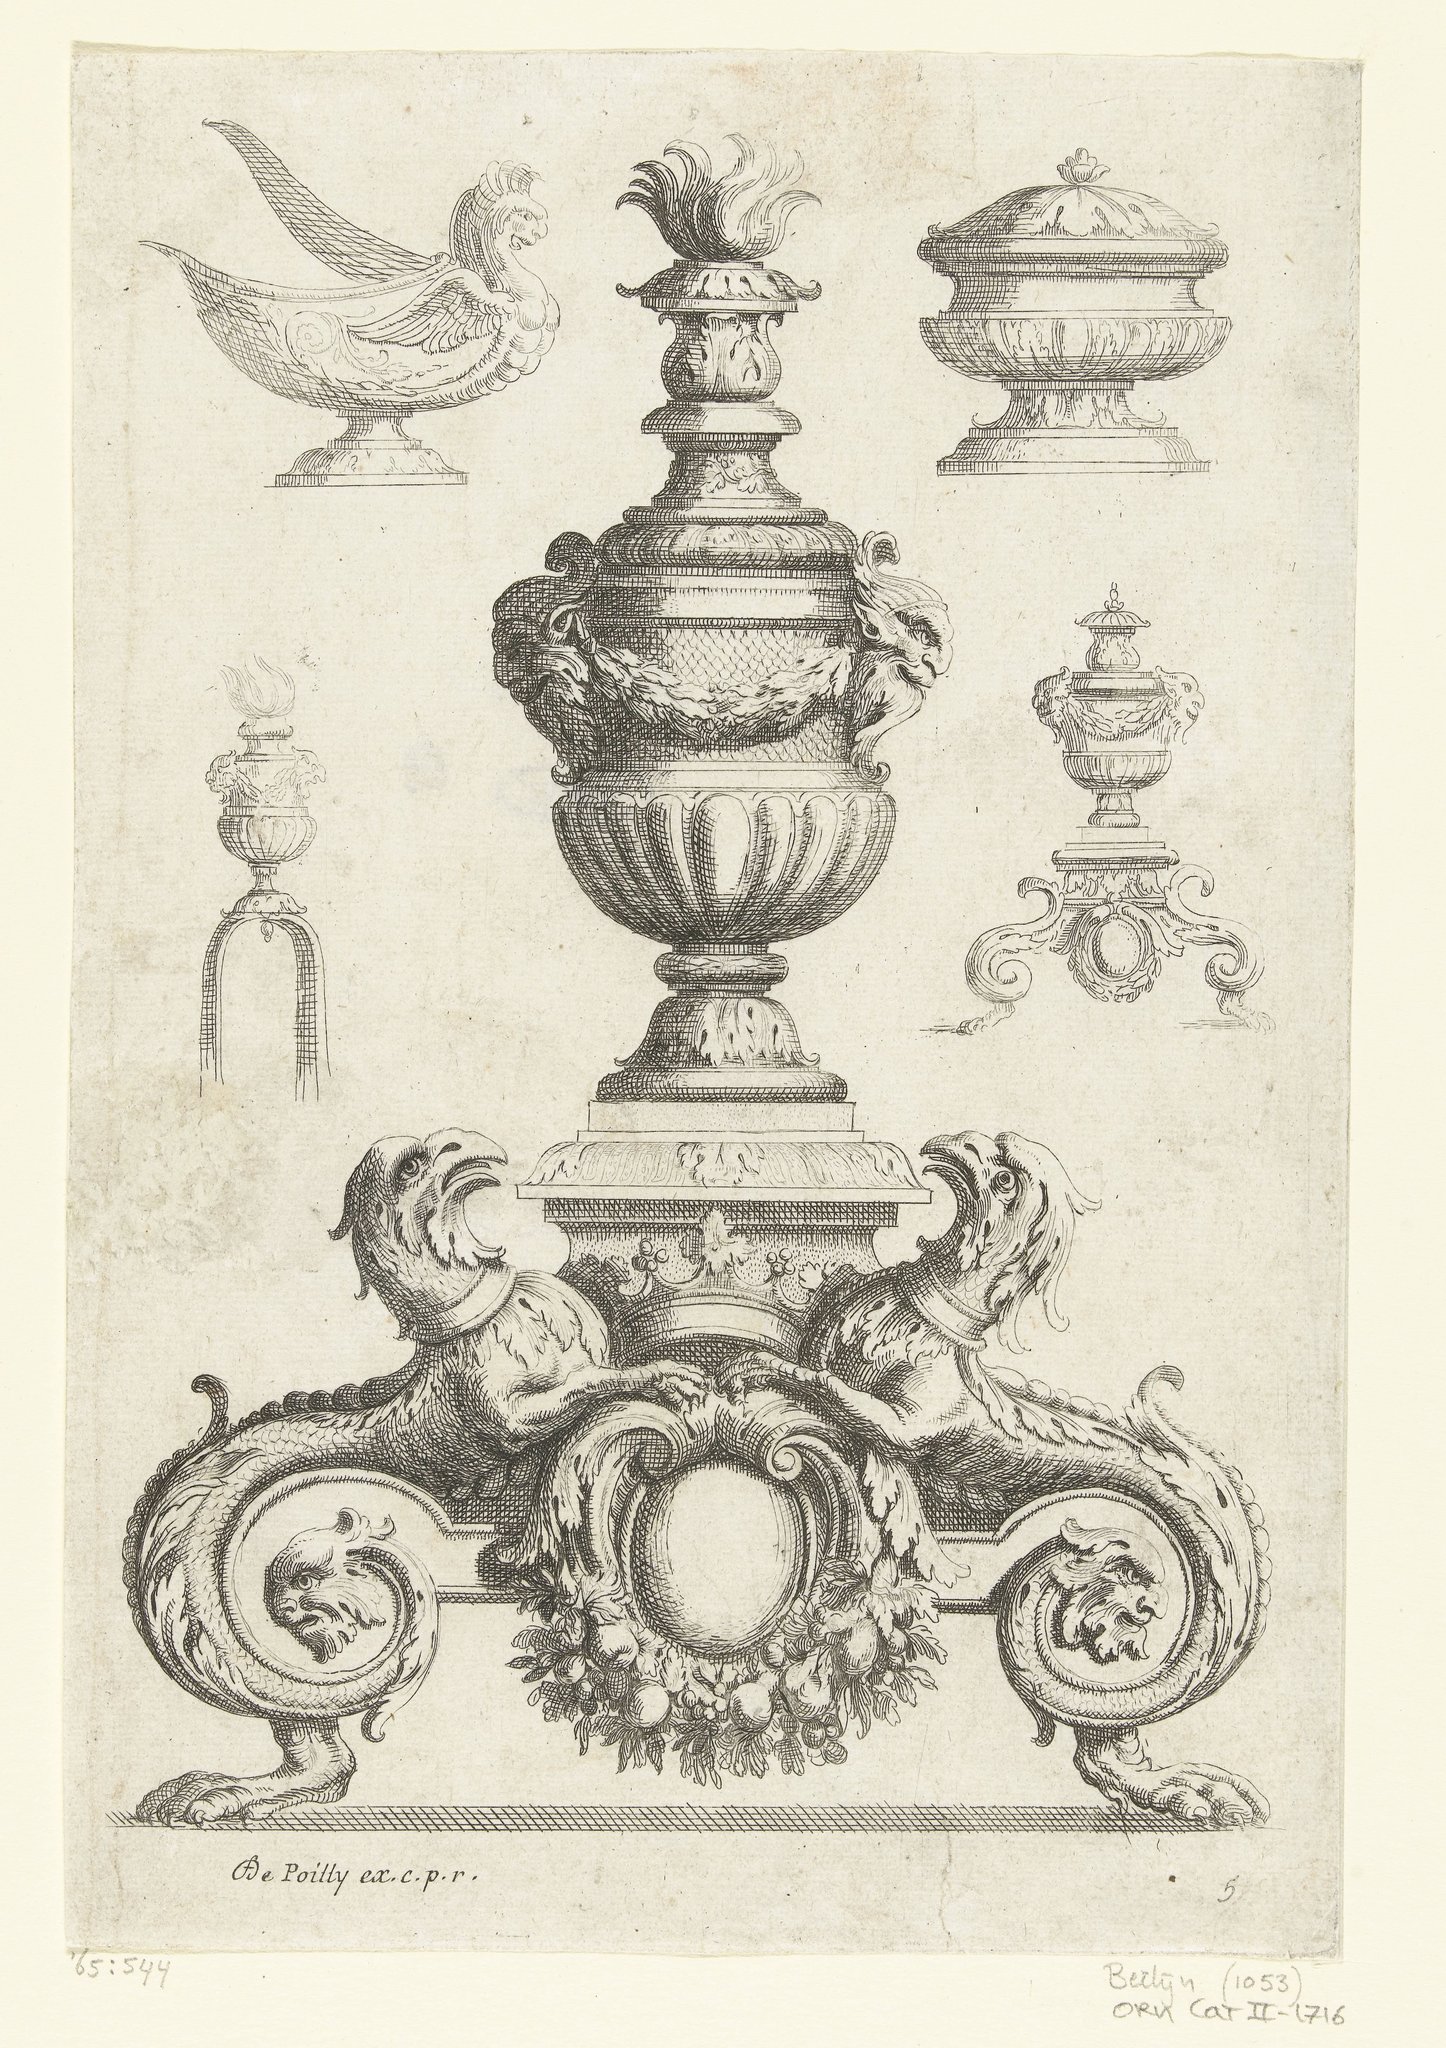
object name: print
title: Vuurbok met urn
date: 1669-1693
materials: paper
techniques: etching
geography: france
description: Vuurbok met urn en griffioenen, variant op hetzelfde ontwerp, handvat van pincet, kleine kom met deksel en een doos. De serie bestaat uit een titelblad en vijf bladen.